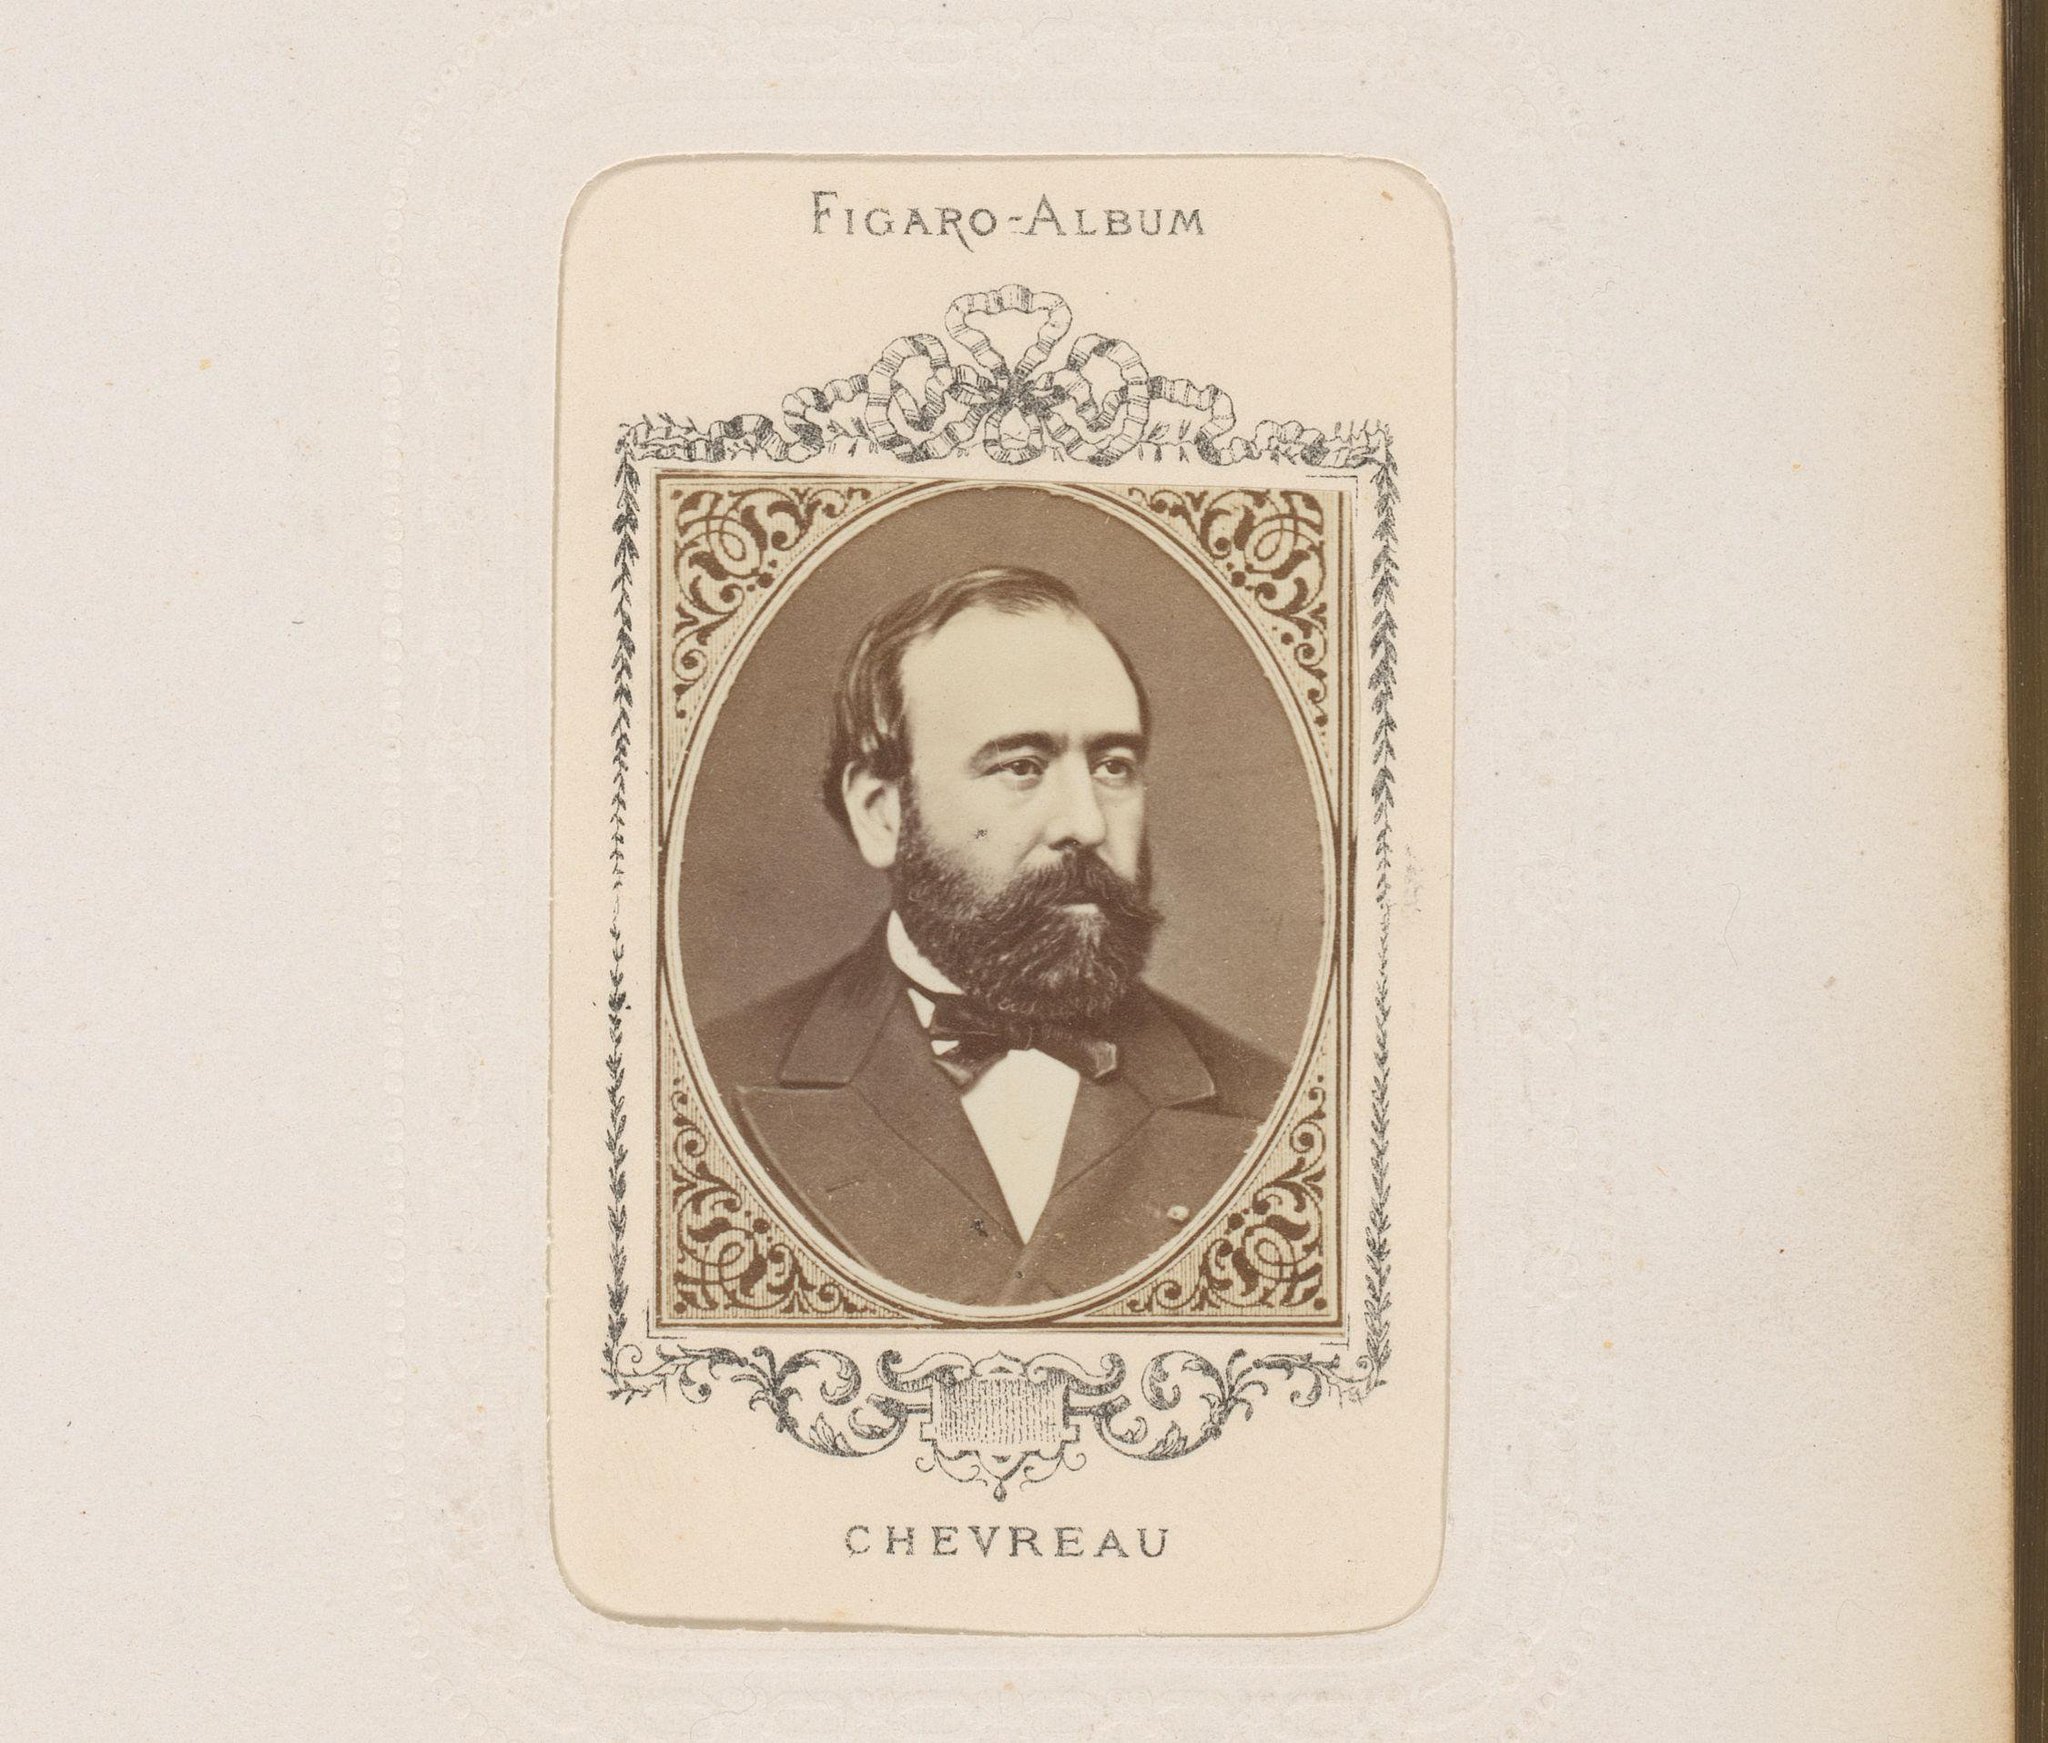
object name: carte de visite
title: Fotoreproductie van een portret van Henri Chevreau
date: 1860-1900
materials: cardboard, photographic support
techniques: albumen print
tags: historical persons, politician, e.g. party leader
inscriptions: inscription: ‘Figaro-Album/ Chevreau/ Liébert Phot.’